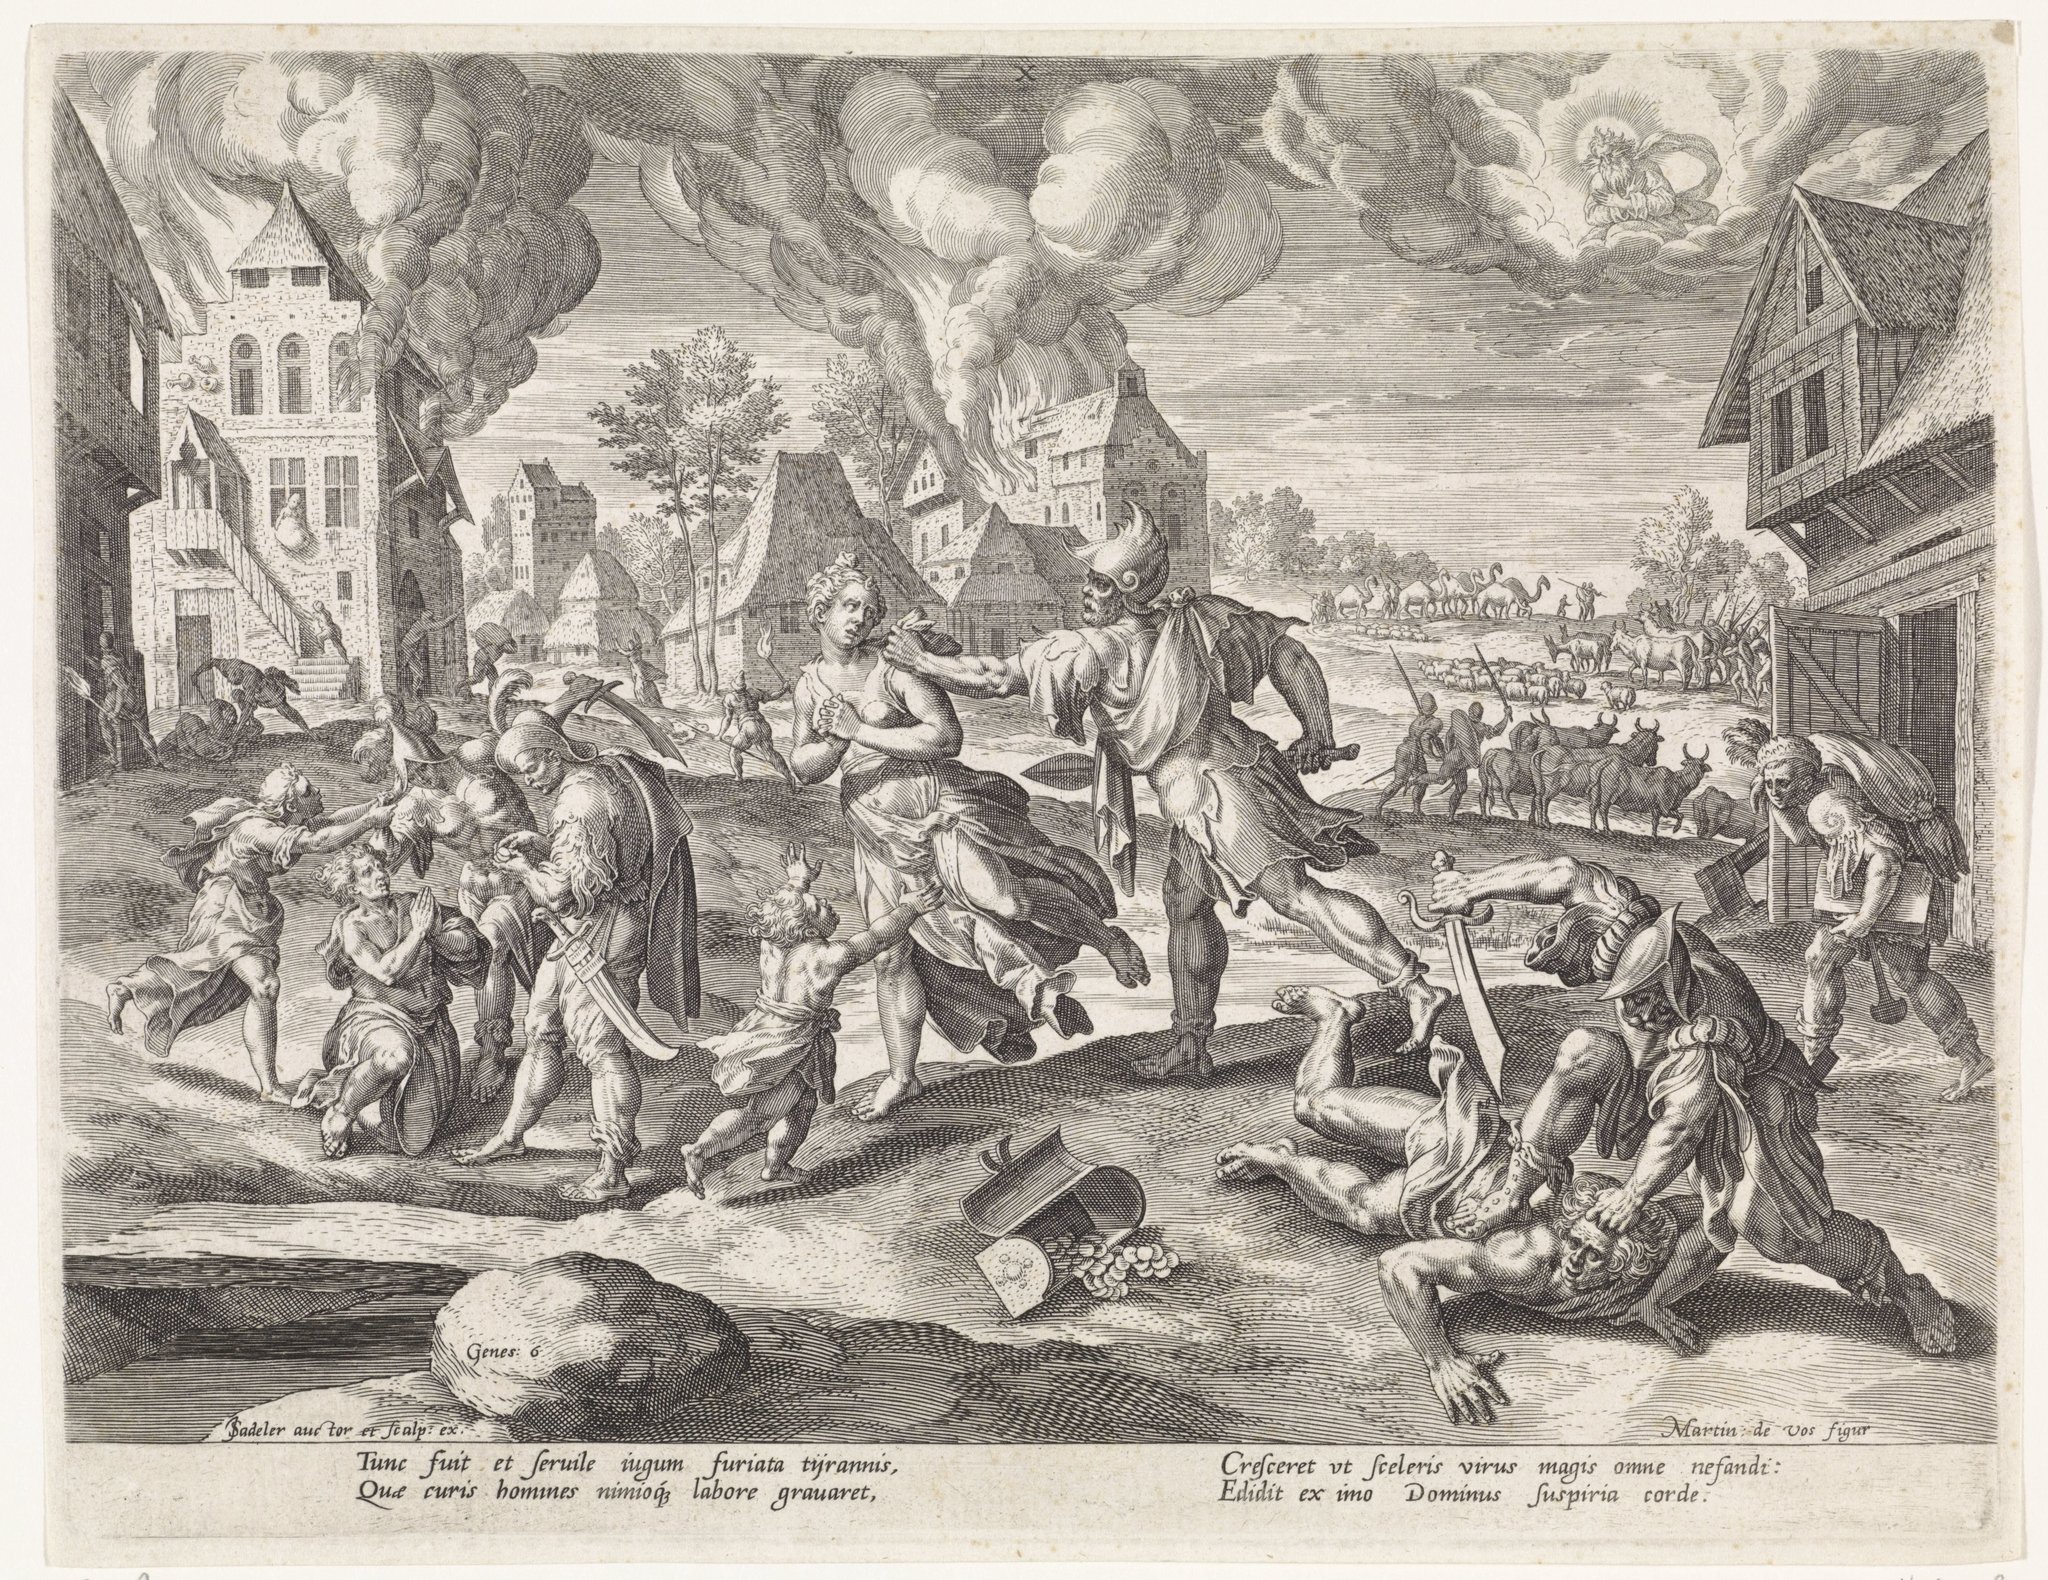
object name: print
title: Verdorvenheid en geweld op aarde vóór de zondvloed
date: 1586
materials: paper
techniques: engraving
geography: antwerp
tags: god the father as bearded old man, usually with crown or tiara or sceptre and/or globe, the wickedness of mankind; the wicked are usually shown feasting and revelling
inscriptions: collector's mark: Lugt 240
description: Op de voorgrond worden mannen, vrouwen en kinderen aangevallen door soldaten of rovers. Ze stelen hun bezittingen en steken hun huizen in brand. God kijkt toe vanuit de wolken. De prent heeft een Latijns onderschrift.